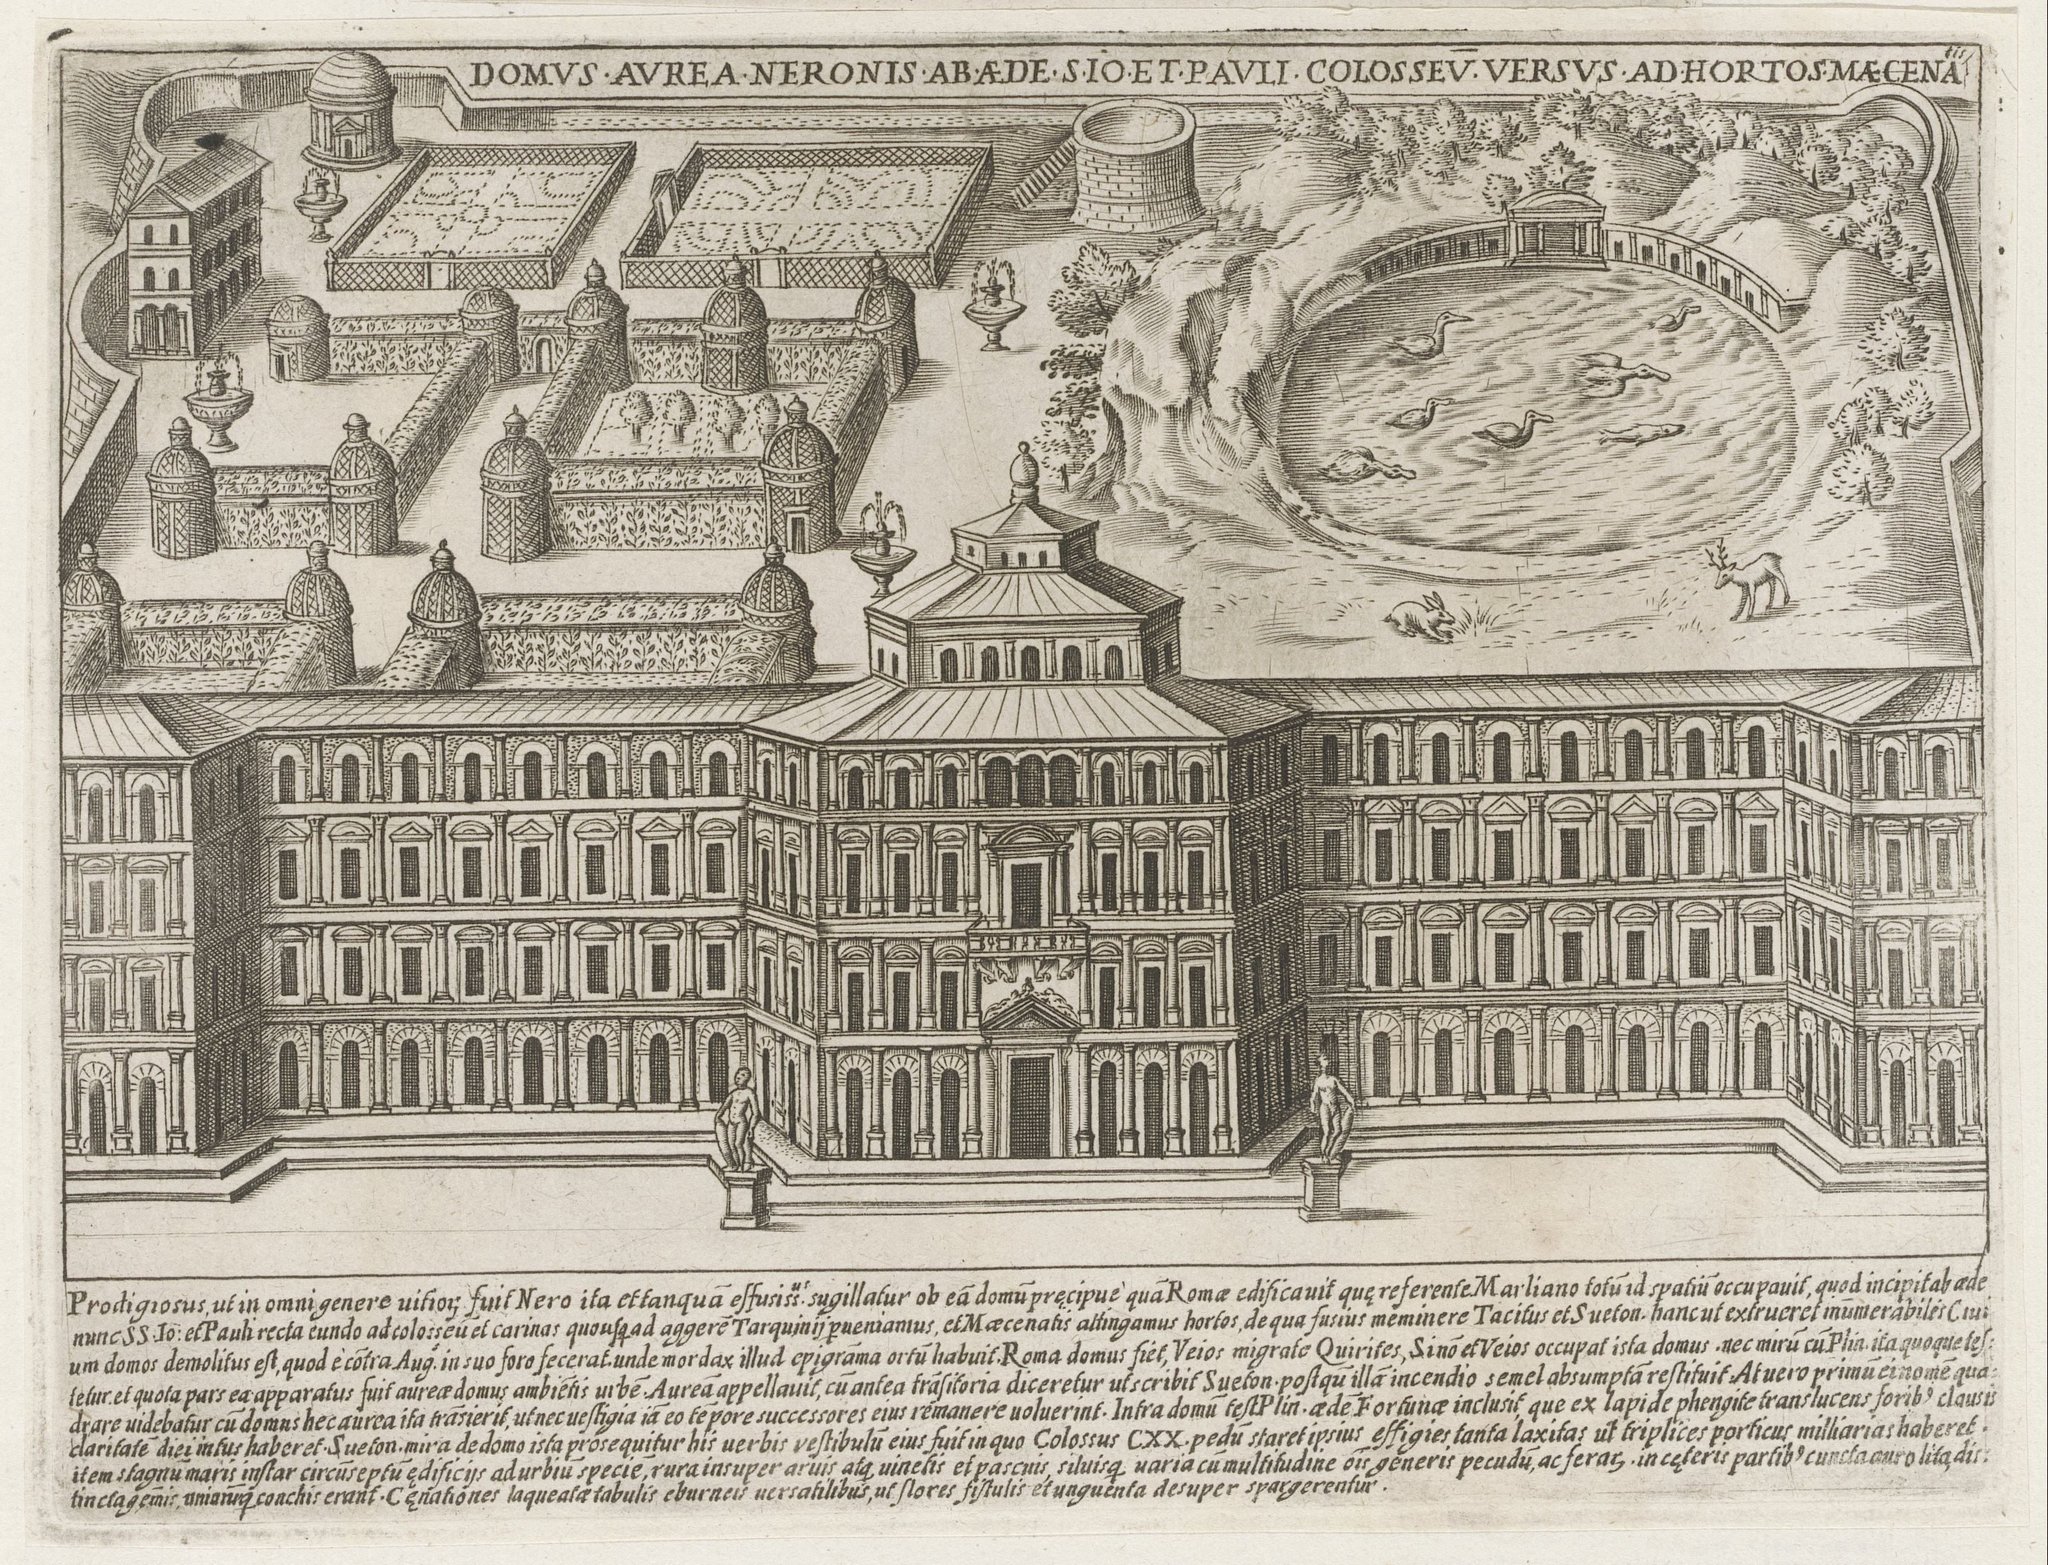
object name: album leaf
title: Domus aurea Neronis ad aede s. io et Pauli Colosseu versus ad hortos maesena.tis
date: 1612-1628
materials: paper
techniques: etching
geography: rome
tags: palace, representation of real building (either existing or having existed)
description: Deze prent maakt deel uit van een set van 158 prenten (+ titelprenten), die verscheen in vier delen. In 1612 verschenen delen één en twee. In 1615 verscheen het derde deel en in 1628 verscheen deel vier. In 1637 publiceerde Vitale Mascardi de eerste heruitgave van de gehele set met nummering.